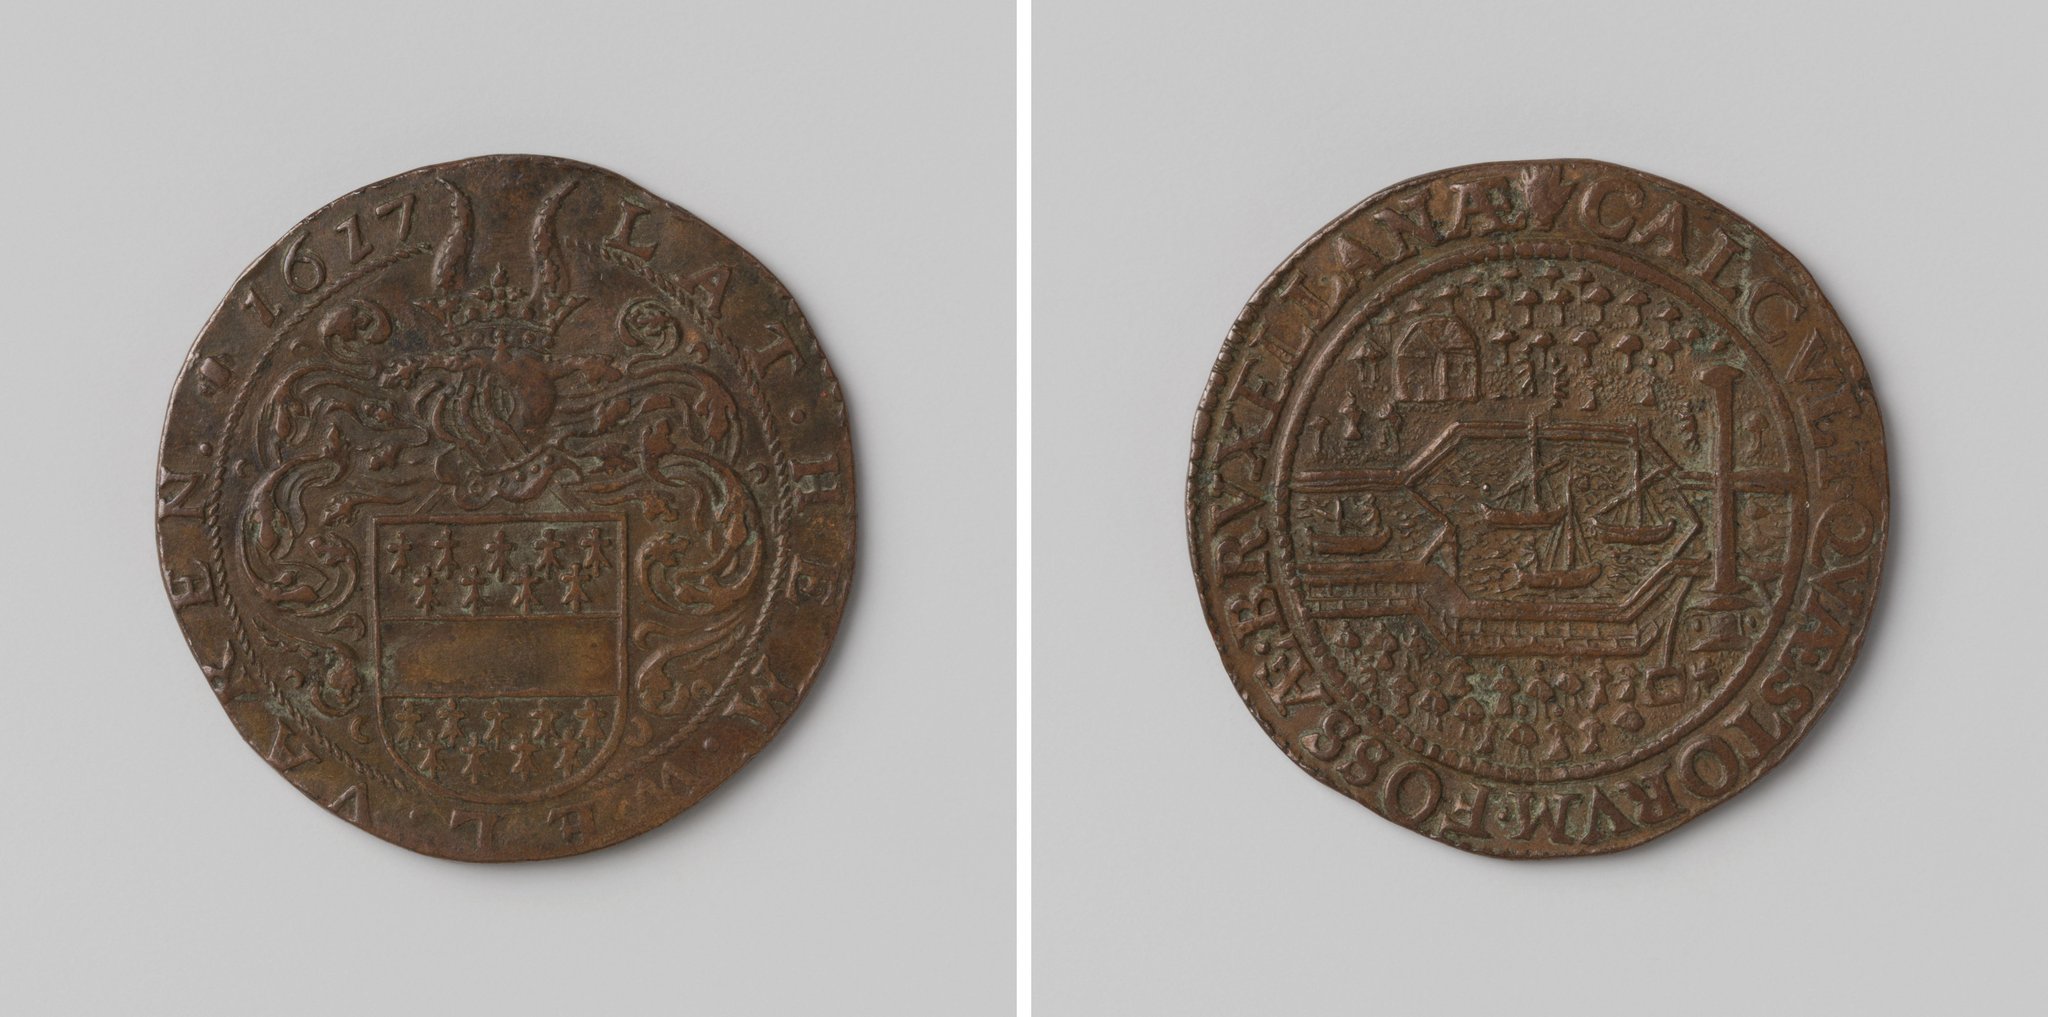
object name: jeton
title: Charles van Laethem, negentiende intendant van de vaart van Brussel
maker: Anonymous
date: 1617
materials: copper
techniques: striking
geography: antwerp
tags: charles van laethem, willebroekse vaart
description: Koperen penning. Voorzijde: gehelmd wapenschild binnen omschrift. Keerzijde: vier zeilschepen in sluis van Trois Fontaines binnen omschrift